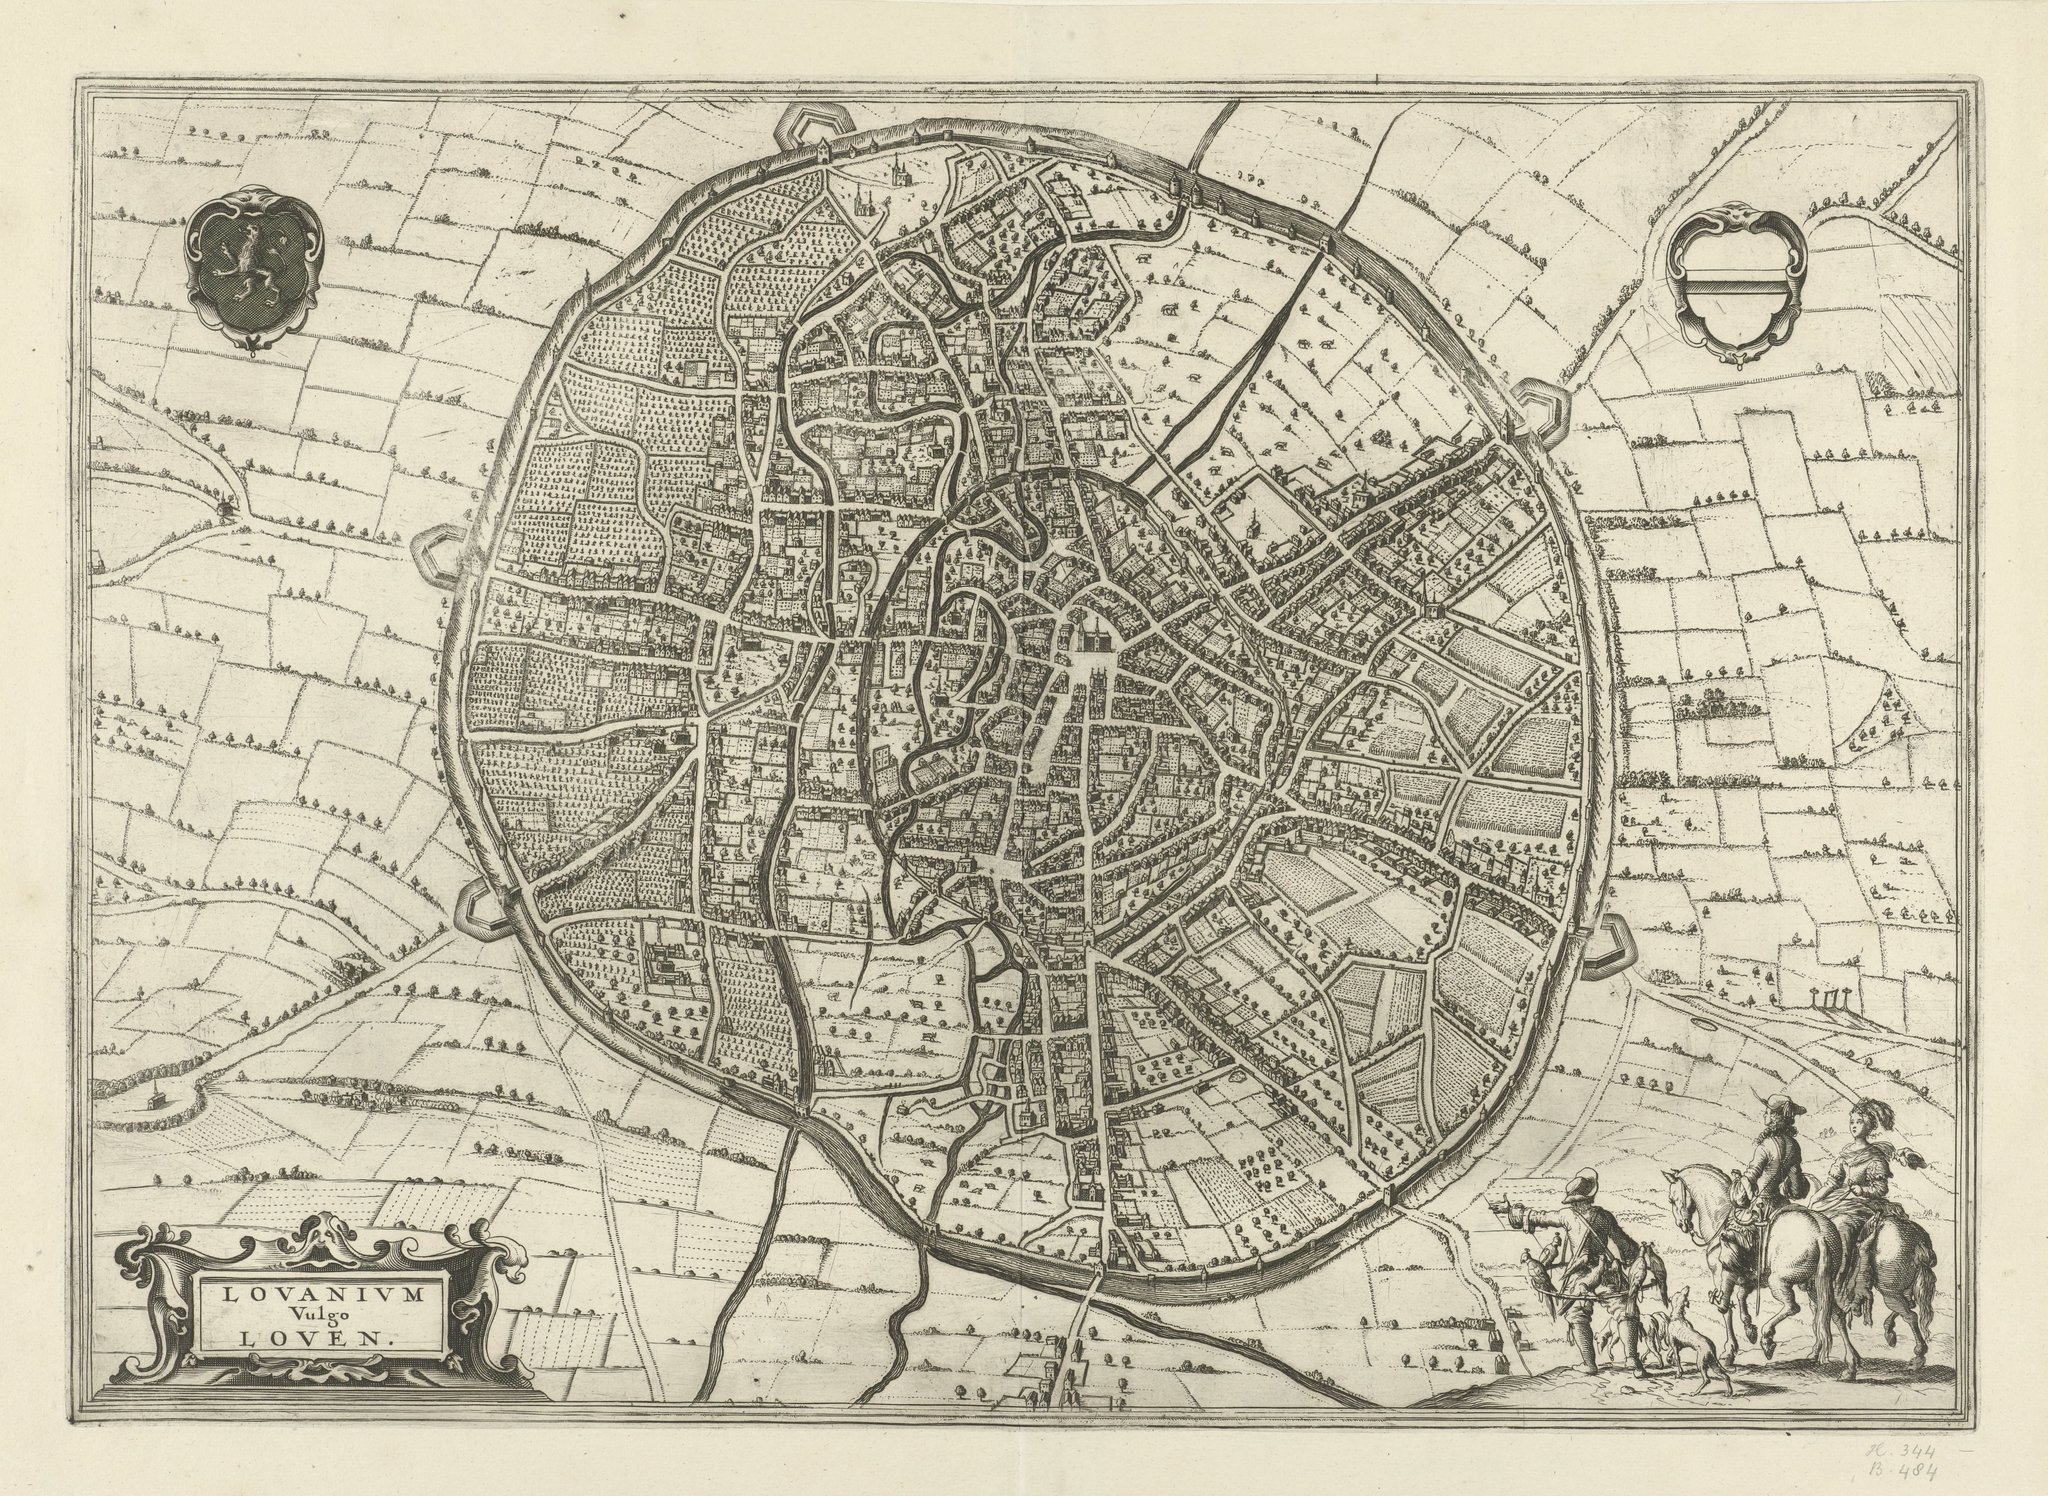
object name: book illustration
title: Plattegrond van Leuven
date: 1581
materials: paper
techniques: etching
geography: amsterdam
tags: maps of cities, louvain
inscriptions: collector's mark: Lugt 2228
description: Kaart opgenomen in: Janssonius van Waesberge, Johannes. Tooneel der vermaarste koop-steden en handel-plaatsen van de geheele wereld. Amsterdam: Johannes Janssonius van Waesberge II, 1682. Eerste staat opgenomen in: Braun, Georg. Civitates orbis terrarum, 6 delen. Keulen: Peter von Brachel en Gottfried von Kempen, 1572-1618, dl. III (1581).